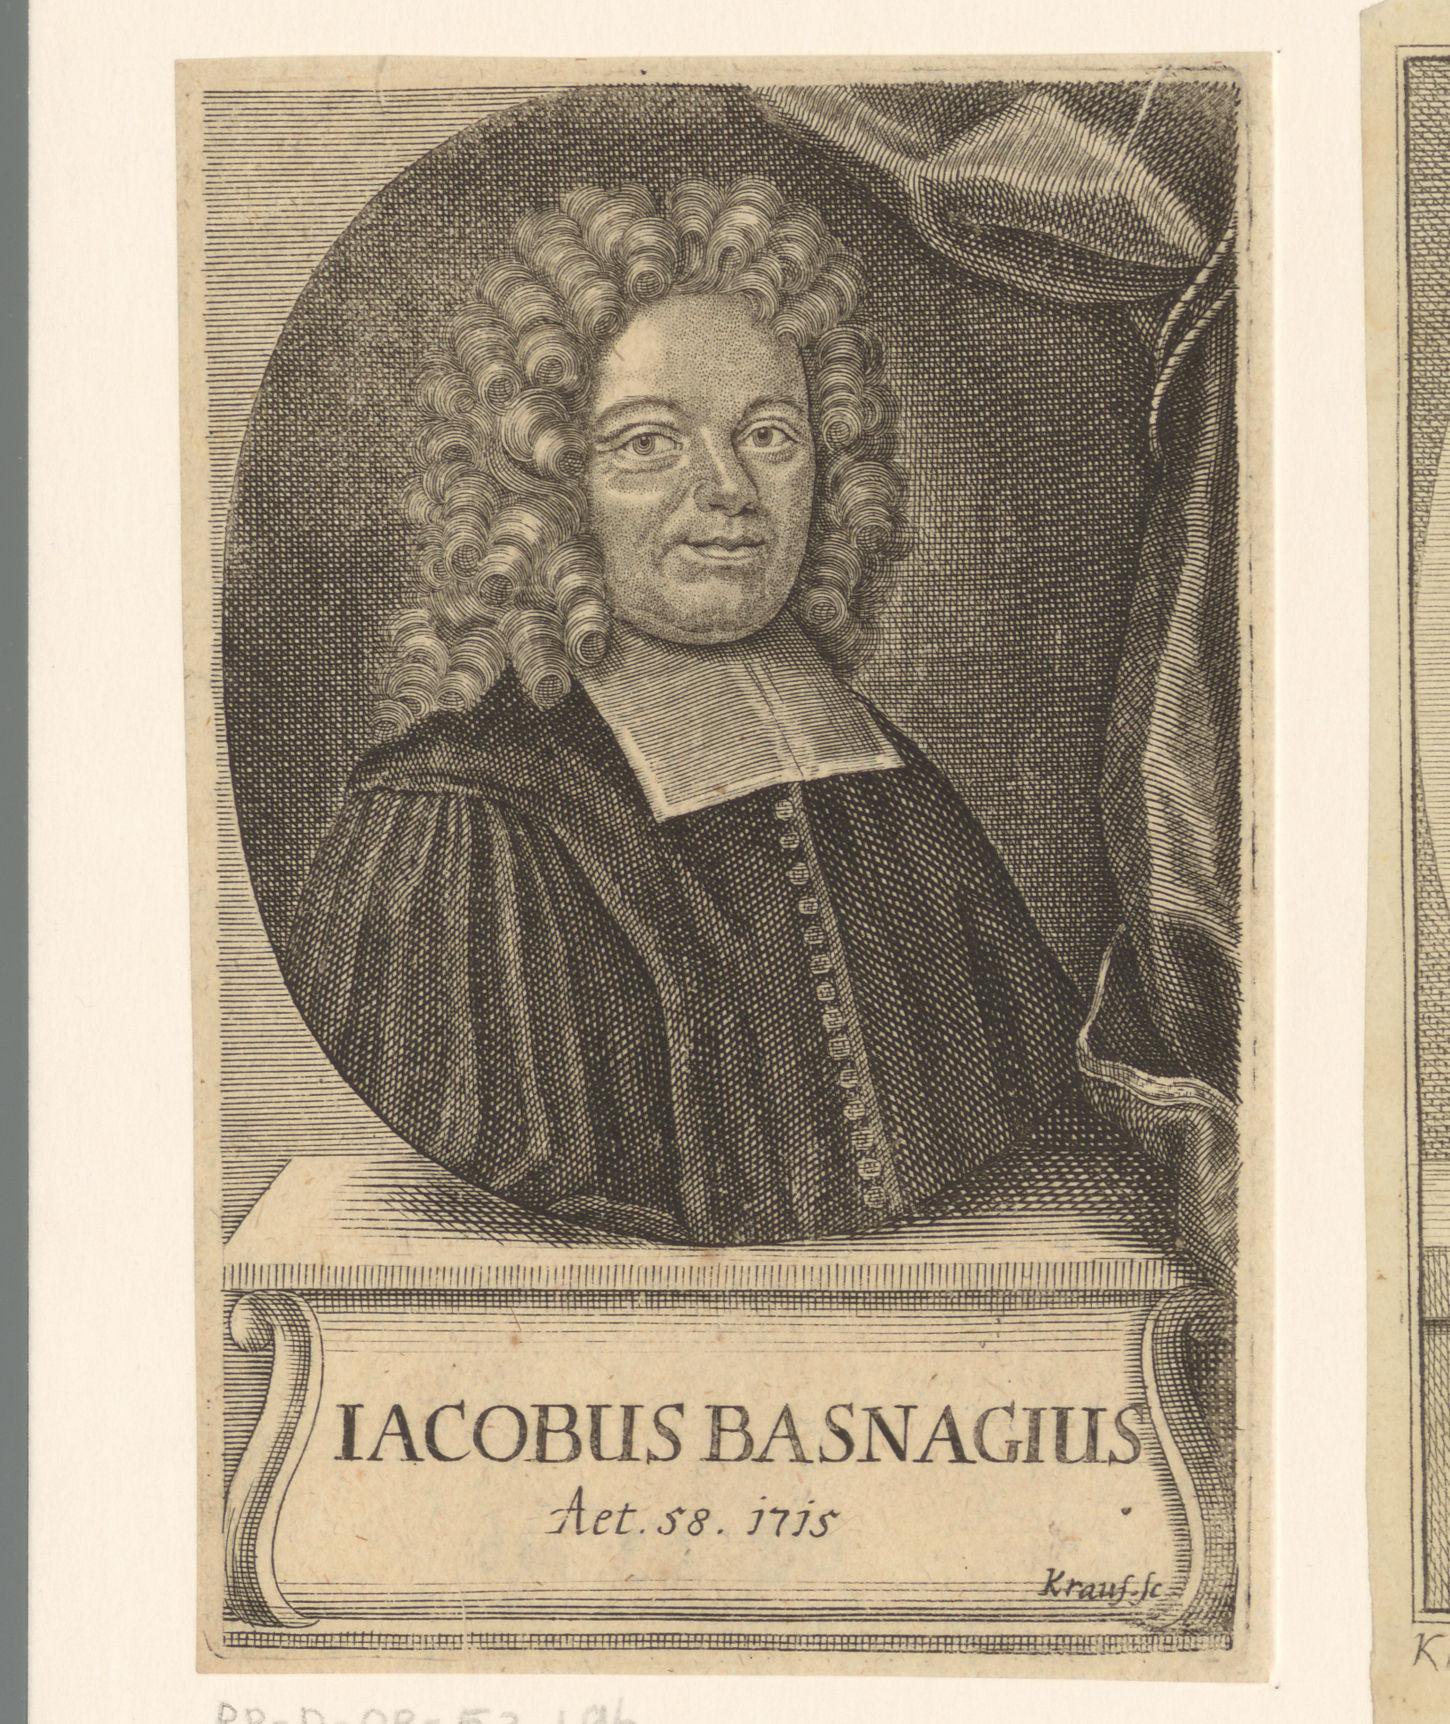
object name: print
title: Portret van Jacques Basnage de Beauval op 58-jarige leeftijd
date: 1715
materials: paper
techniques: engraving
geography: leipzig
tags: the hague, theologian, historical persons, portrait of a writer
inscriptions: collector's mark: Lugt 2228